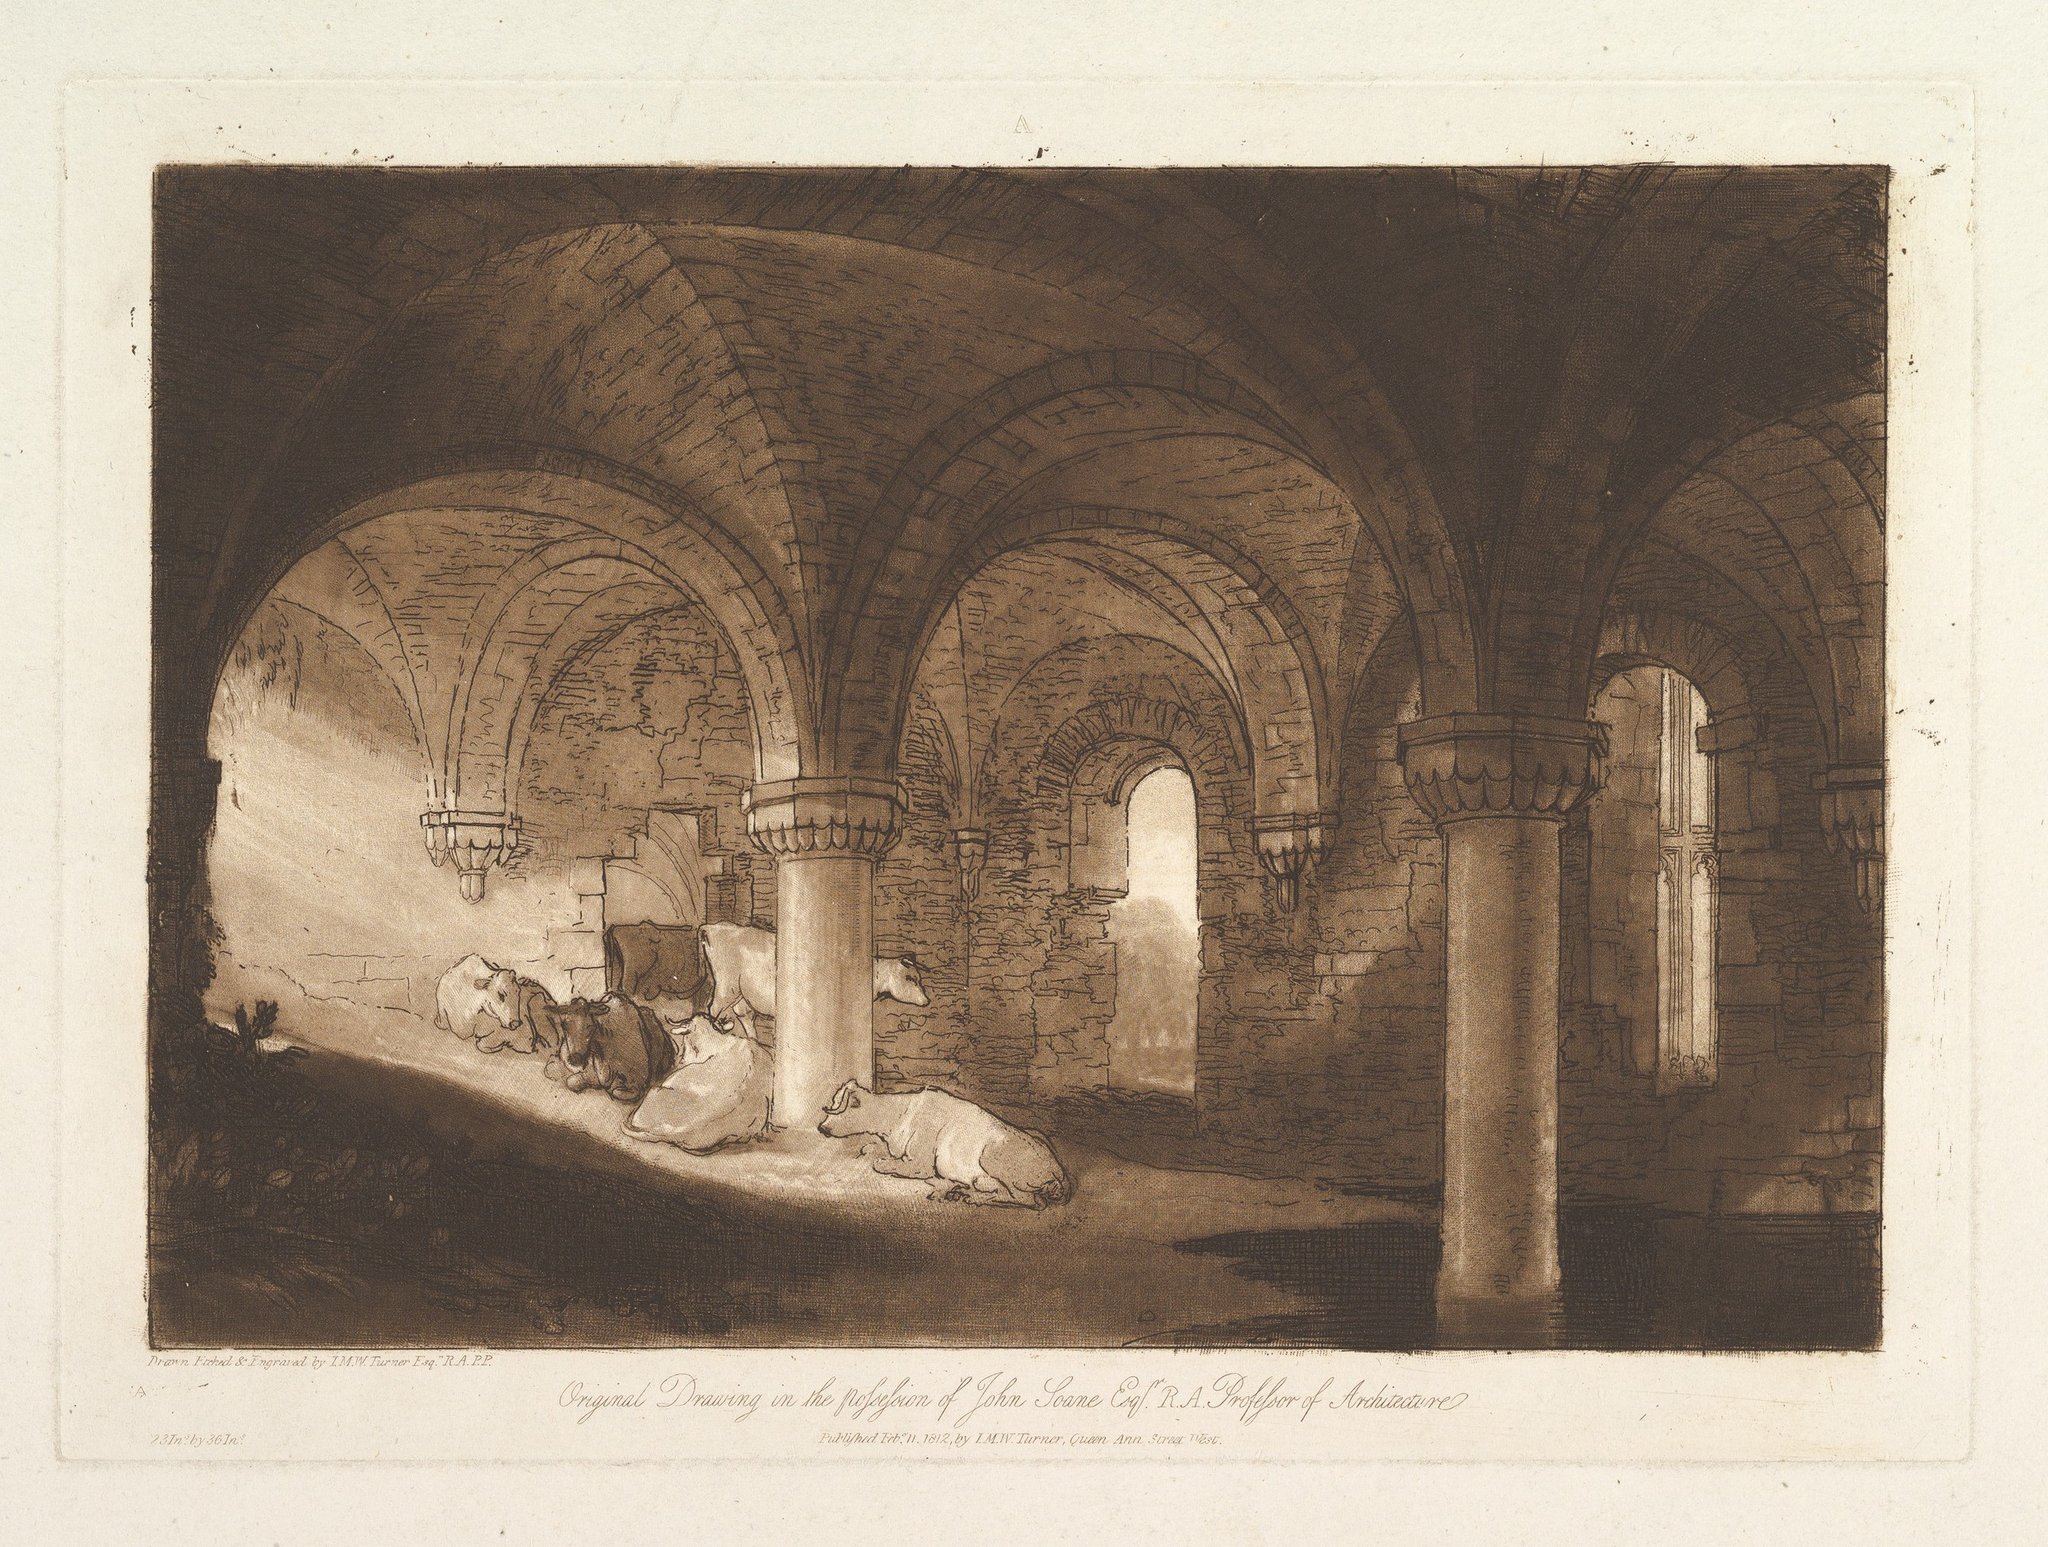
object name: print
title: Crypt of Kirkstall Abbey, part ViII, plate 39 from "Liber Studiorum"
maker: joseph mallord william turner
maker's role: artist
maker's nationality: british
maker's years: 1775-1851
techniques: aquatint, etching, mezzotint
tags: crypts,abbeys,cows